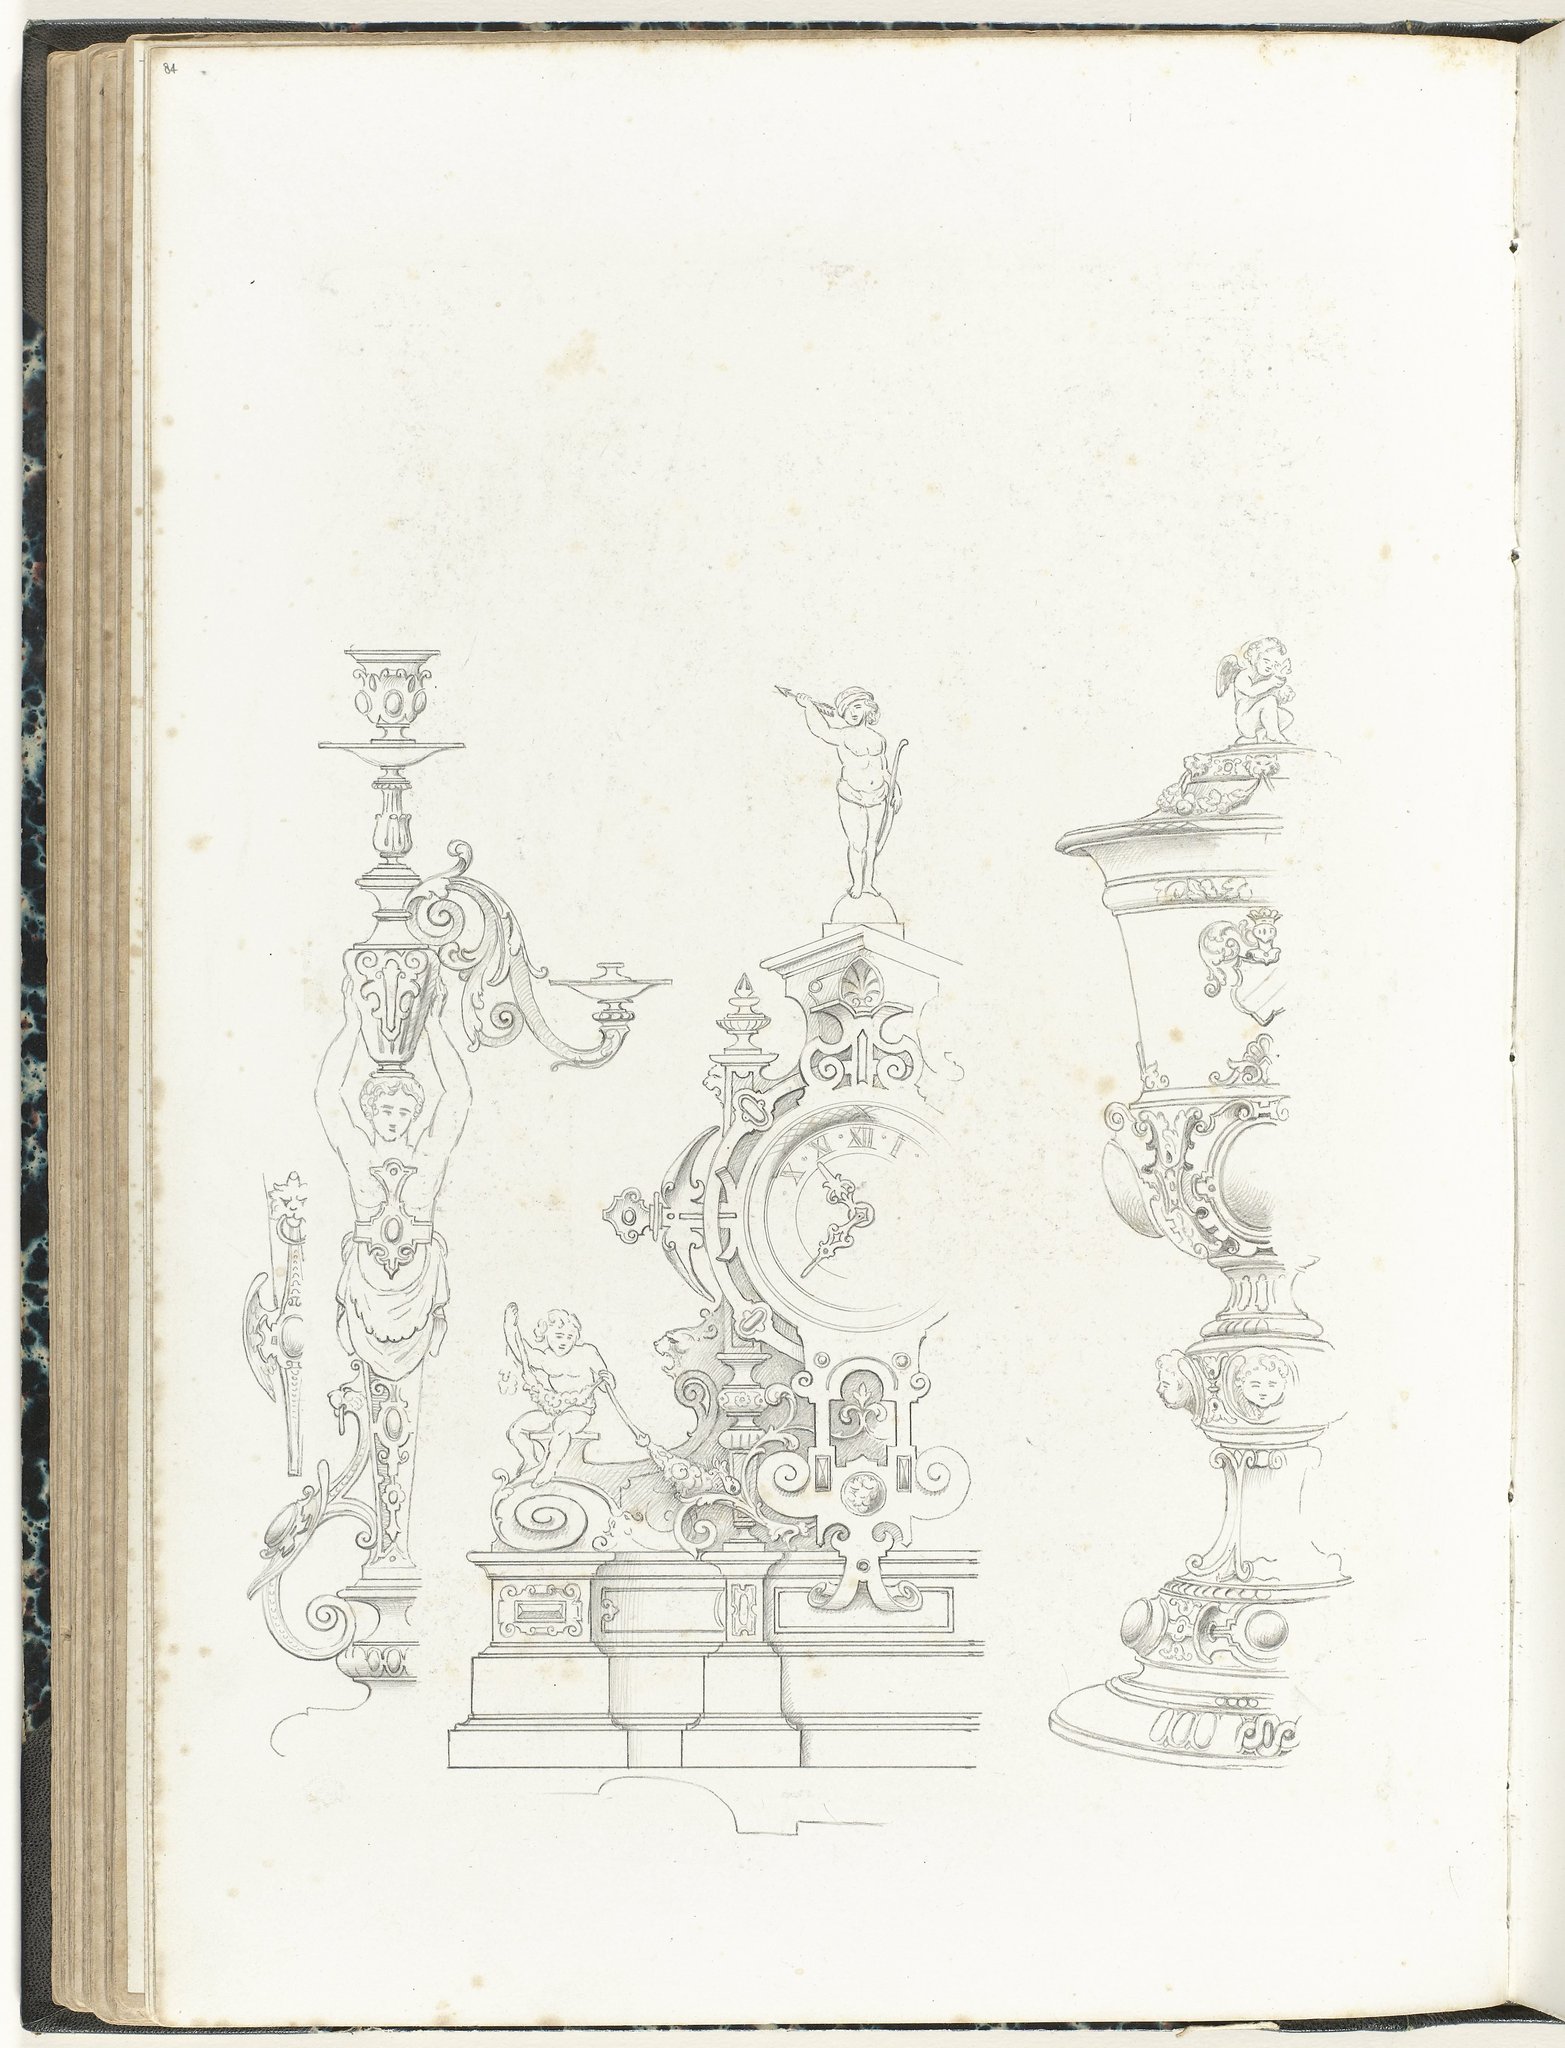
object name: drawing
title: Klein ornament, kandelaar, klok en vaas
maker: Anonymous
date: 1866-1900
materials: paper, pencil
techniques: drawing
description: De vier voorwerpen zijn slechts gedeeltelijk afgebeeld. De kandelaar bestaat uit een herme die een kaarsenhouder met twee armen op zijn hoofd draagt.